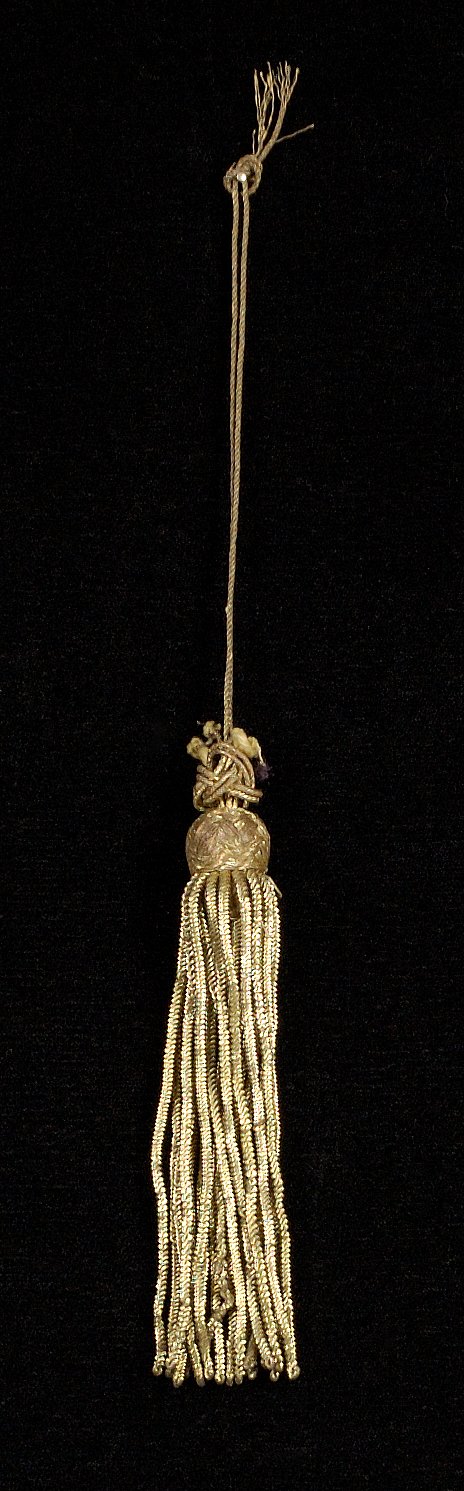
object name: ornament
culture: american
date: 1864-1880